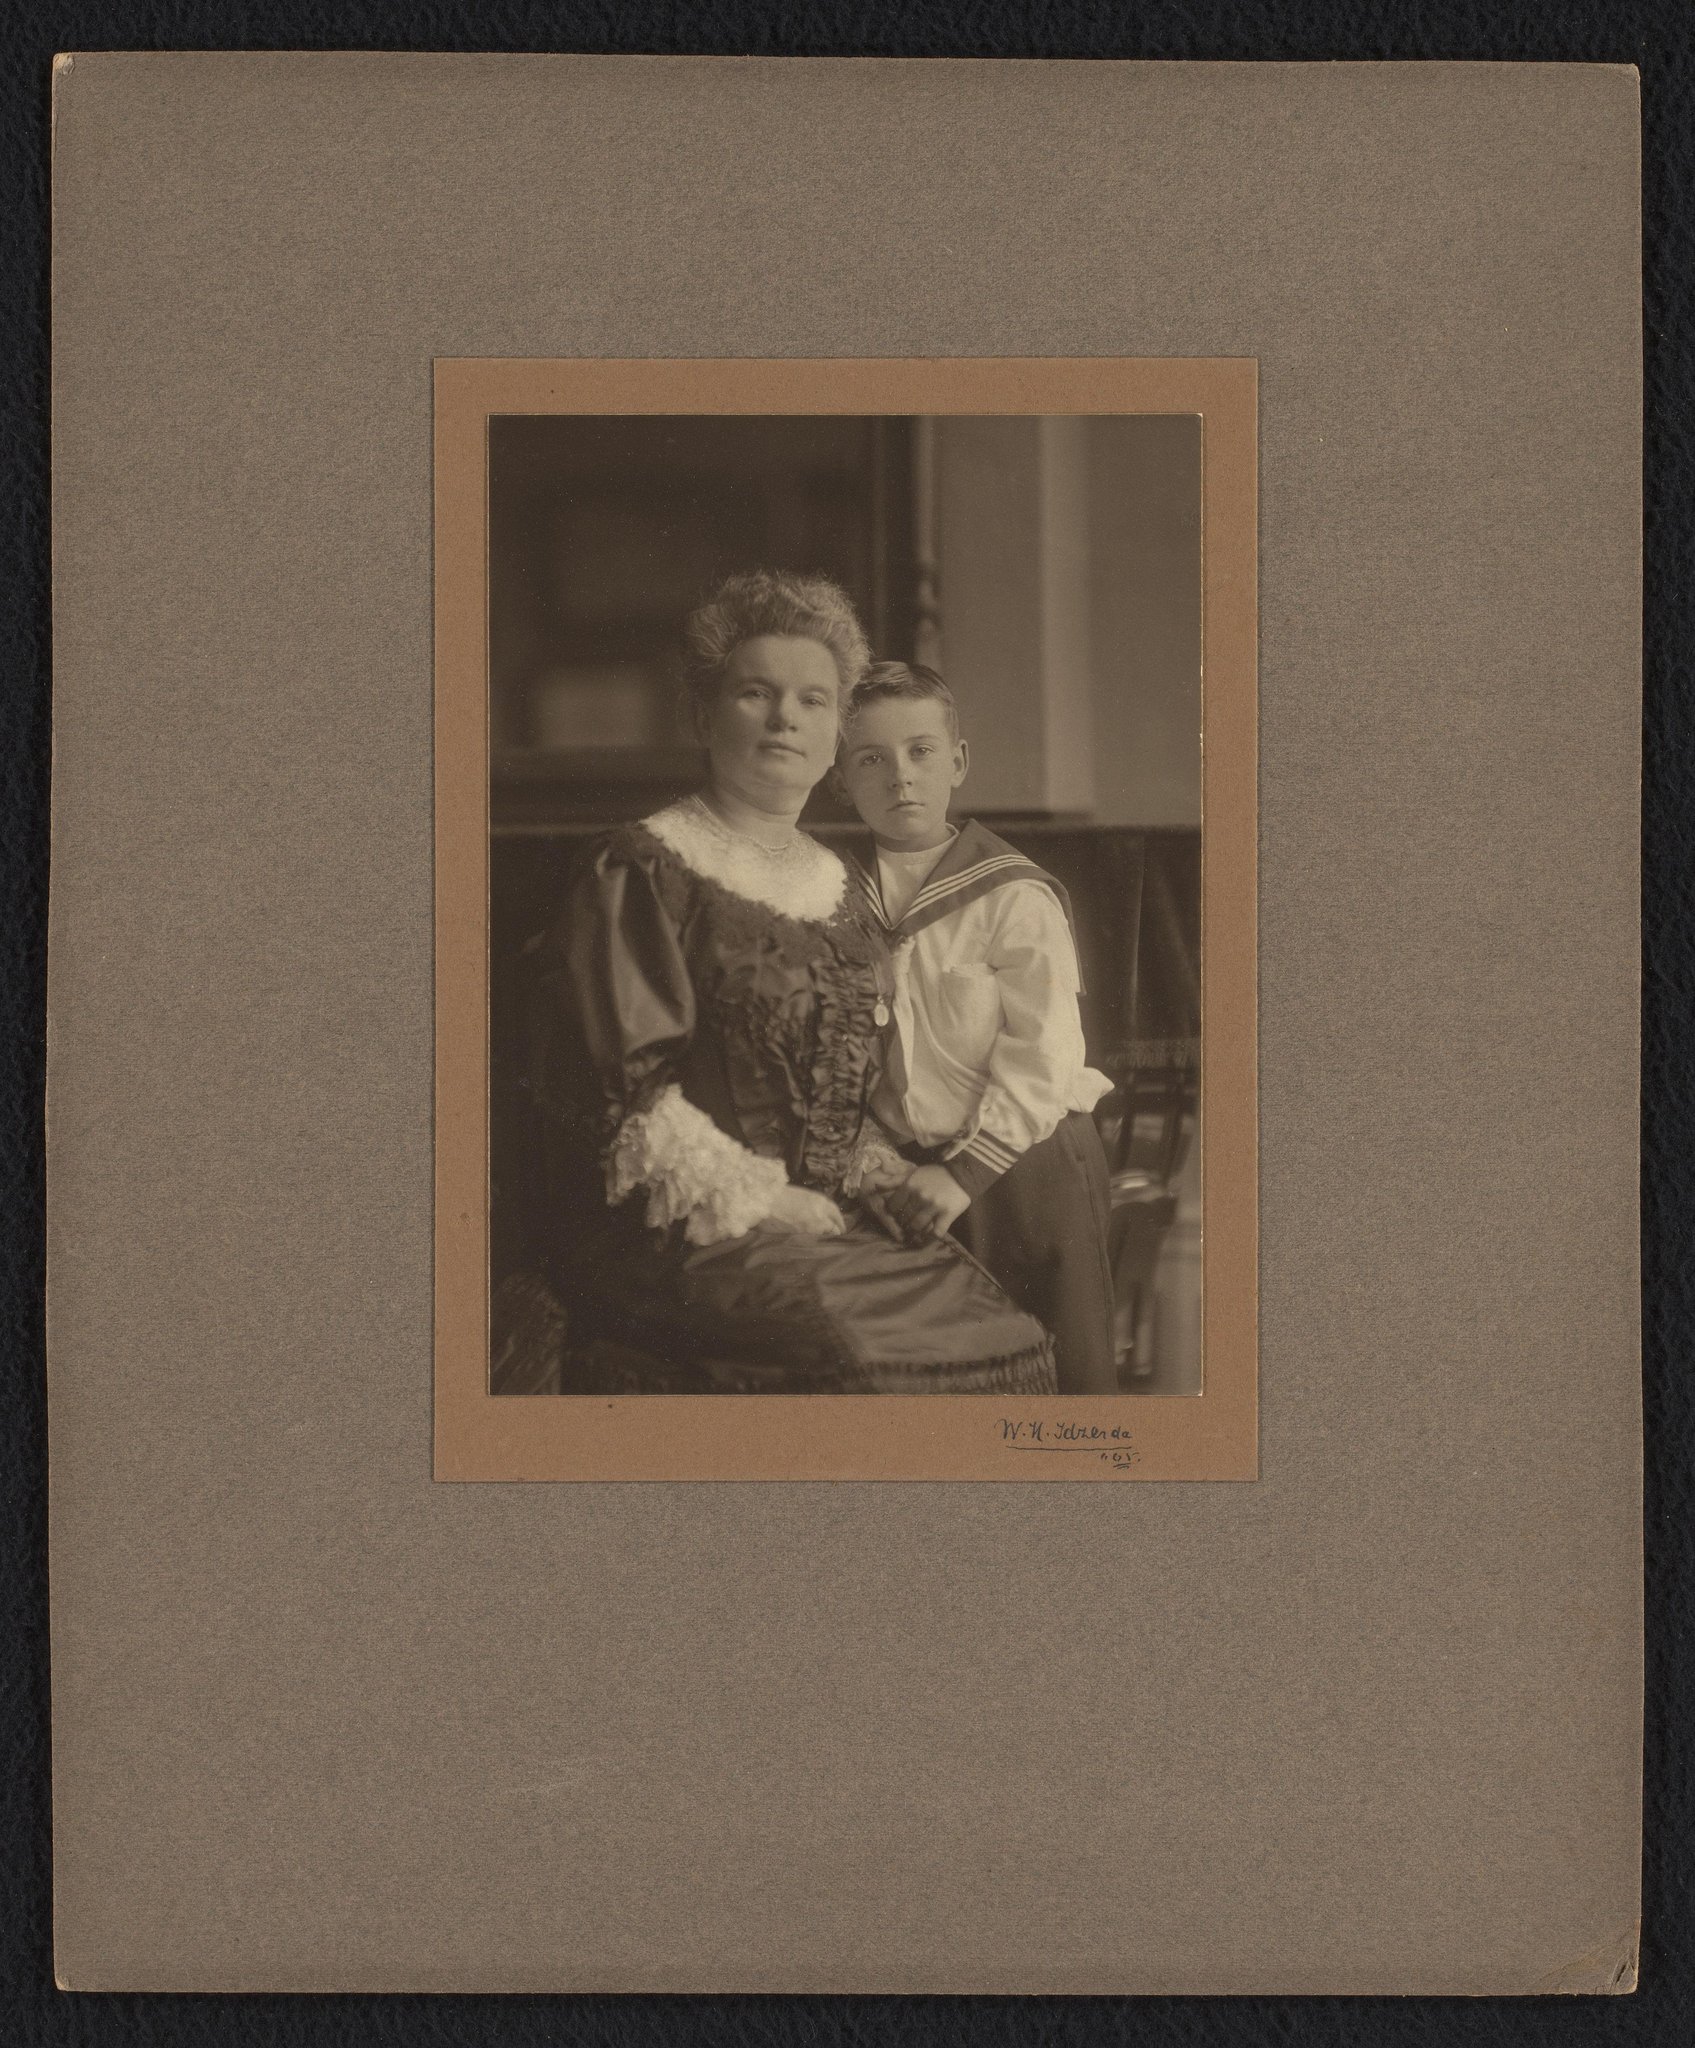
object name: photograph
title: Portret van Margo Kessler-de Lange met haar zoon Boelie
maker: wieger hendricus idzerda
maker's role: fotograaf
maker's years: 1872-1938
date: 1905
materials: cardboard, paper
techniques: carbon print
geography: the hague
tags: margaretha jacoba johanna kessler-de lange (margo), the hague, hermann johannes kessler (boelie), mother and son(s) (family group), historical persons